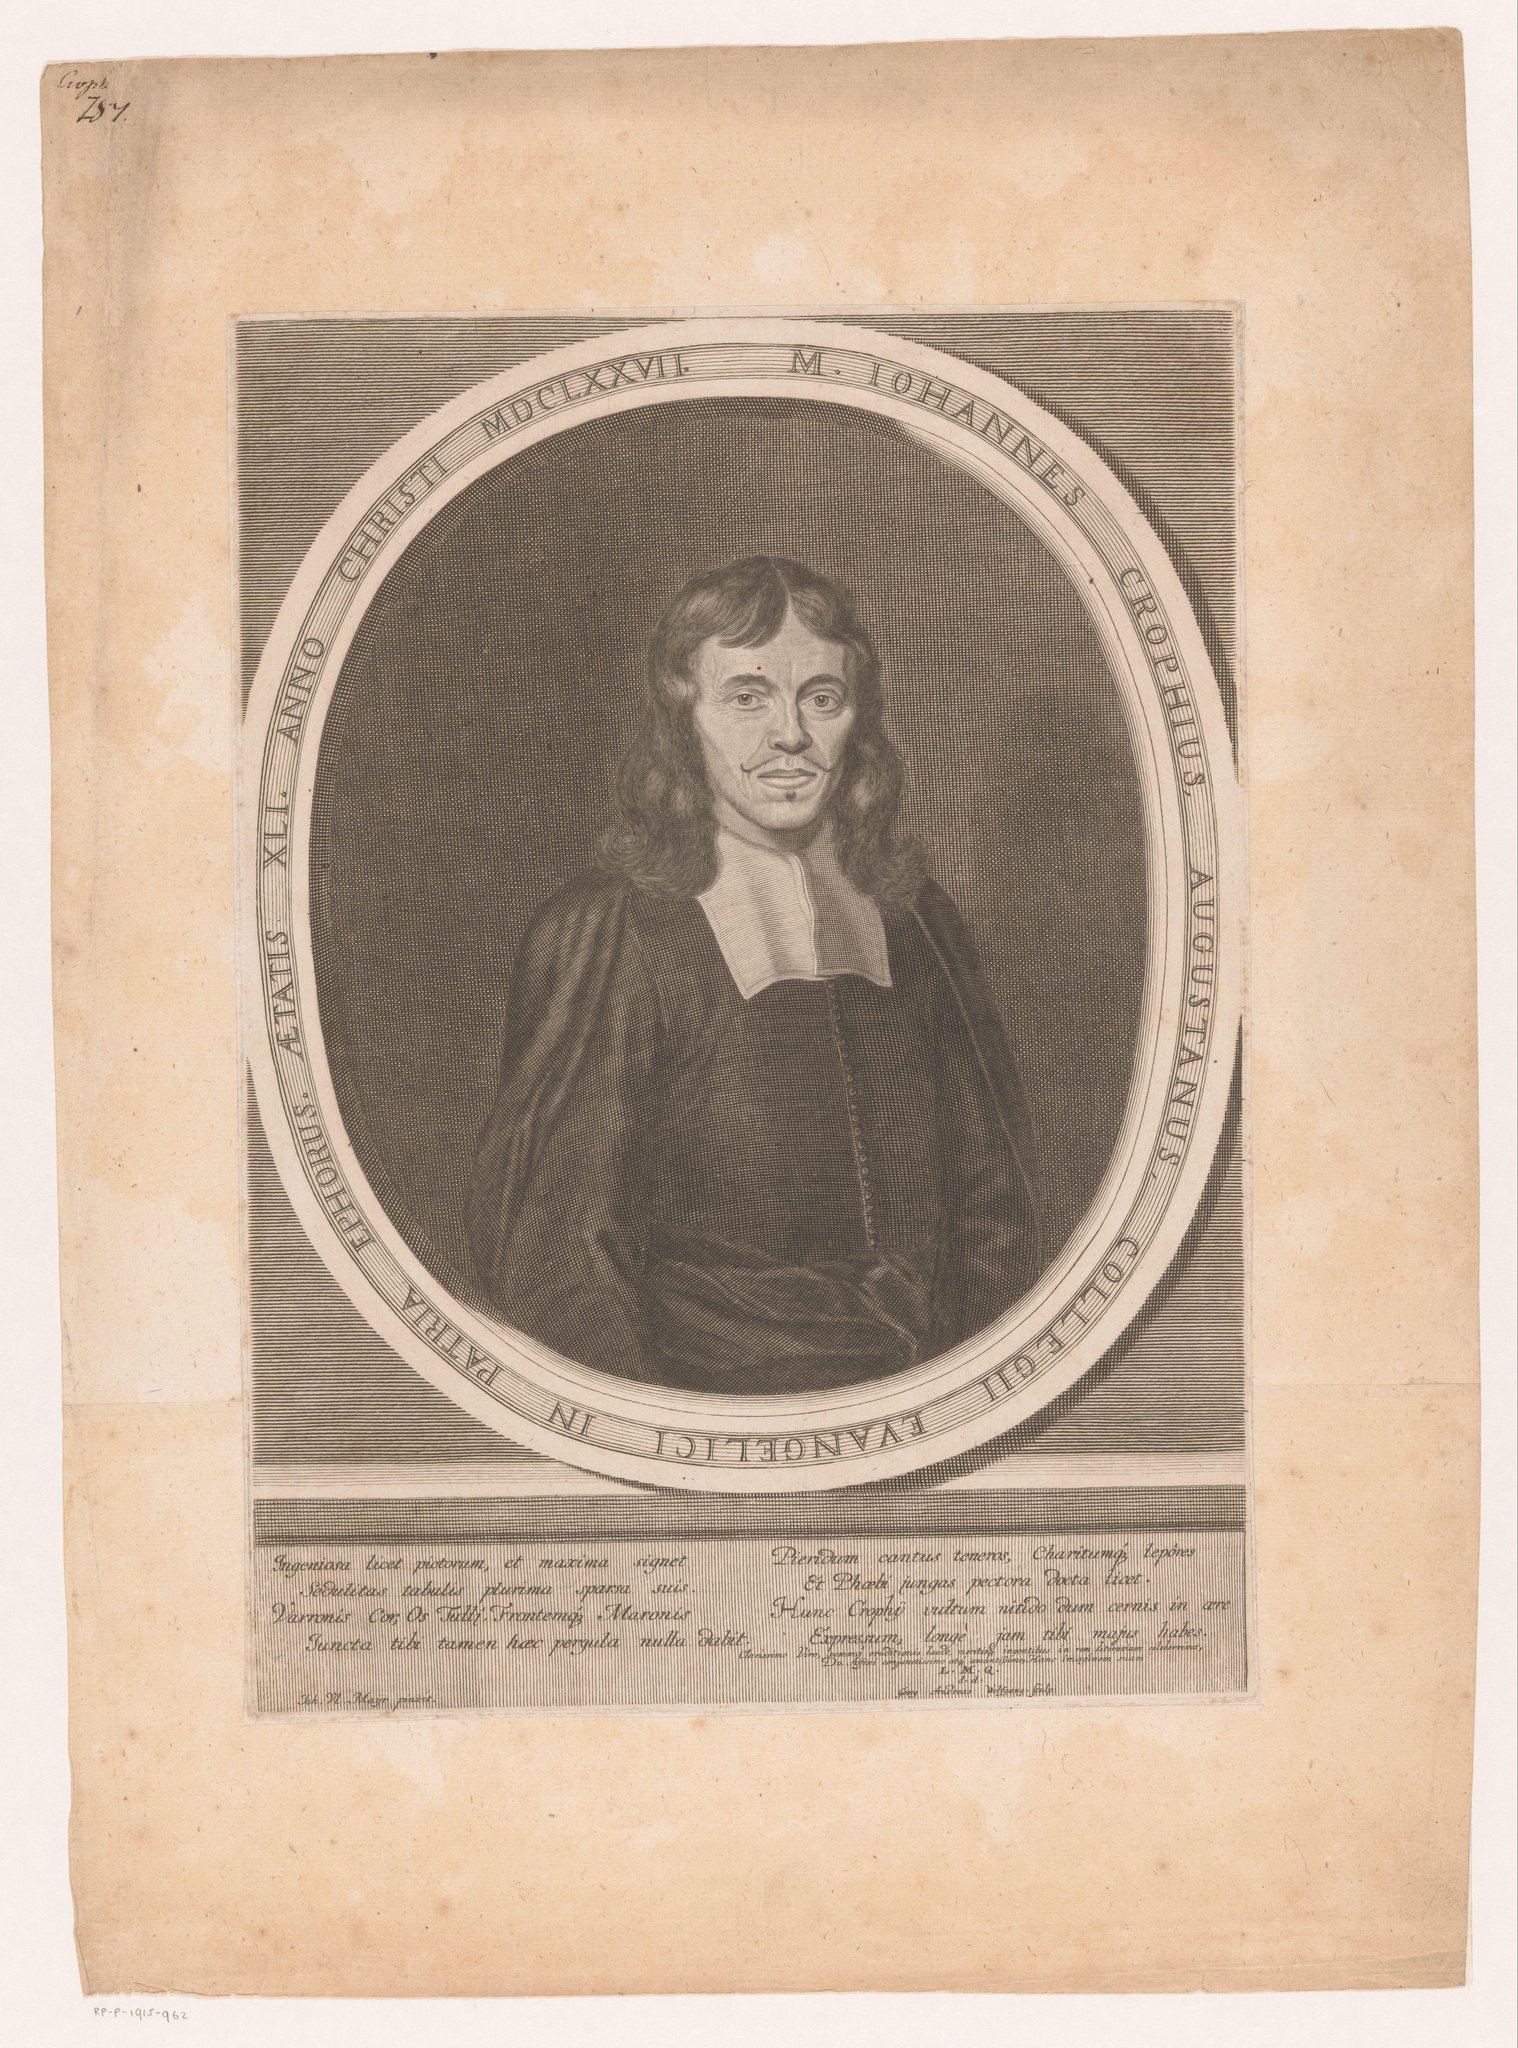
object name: print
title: Portret van Johann Croph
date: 1677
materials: paper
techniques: engraving, etching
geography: germany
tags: augsburg, historical persons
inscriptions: collector's mark: Lugt 2228